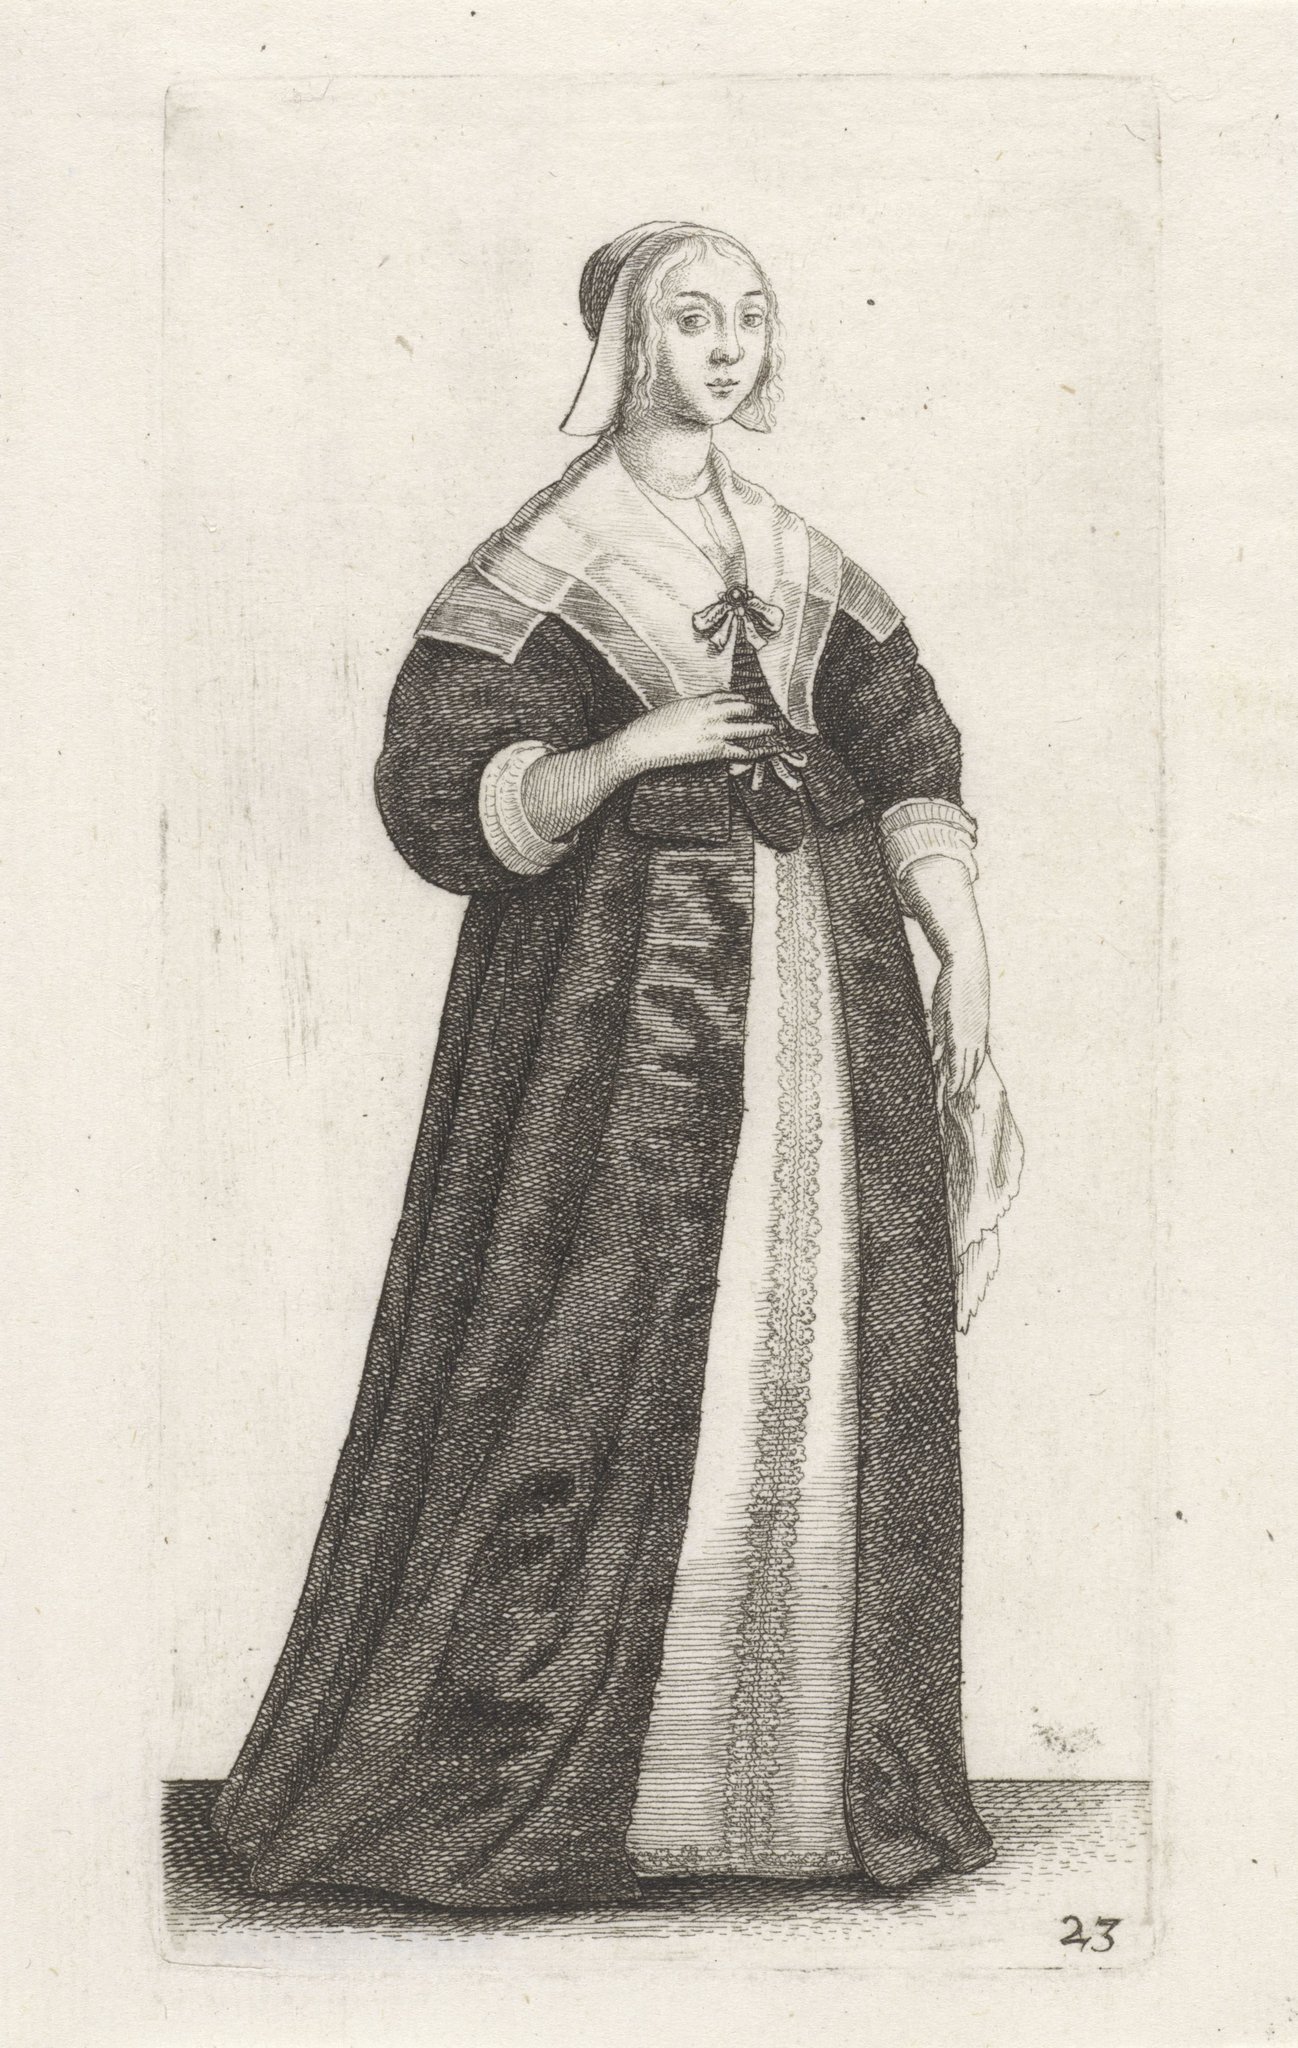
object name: costume print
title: Ornatus Muliebris Anglicanus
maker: wenceslaus hollar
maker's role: draughtsman, print maker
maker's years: 1607-1677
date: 1638-1640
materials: paper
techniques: etching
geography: london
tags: bow (ornamental part of clothing) (+ women's clothes), handkerchief (+ women's clothes), brooch, agraffe, clasp (+ women's clothes), neck-gear ~ clothing (neckerchief) (+ women's clothes), piece of clothing covering the breast or décolleté (stomacher) (+ women's clothes), europeans: englishmen (+ women), skirt (underskirt) (+ women's clothes), styles of hairdress - aa - ~ women, head-gear: cap (+ women's clothes), neck-gear: collar (+ women's clothes), fashion plates, skirt (+ women's clothes), sleeves (+ women's clothes), clothing for the upper part of the body (with name) (+ women's clothes), england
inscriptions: collector's mark: Lugt 654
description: Engelse vrouw, met op het afhangende, krullende haar en scheiding in het midden een mutsje met op het voorhoofd teruggeslagen rand die aan weerszijden van het gezicht verbreedt en naar buiten uitstaat. Gekleed in een japon bestaande uit een kort, open lijf met v-hals, hoge taille, schoot met verschillende panden, wijde lange mouwen en borststuk, op een lange, ruime, open rok enigszins slepend op de grond. Licht gekleurde onderrok. Rond de hals een dun, dichtgeknoopt koordje met afhangende uiteinden. Over het décolleté een dubbelgevouwen onversierde, transparante halsdoek, die middenvoor gesloten wordt met een sieraad en een strik. Hieronder een platte, brede kraag de over de schouders hangt. Of het lijf is over het borststuk dicht geregen, of het borststuk is versierd met kruislings geplaatste linten met onderaan een strik. Dubbele, fijn geplooide, teruggeslagen manchetten. De onderrok is middenvoor versierd met twee verticaal, tegen elkaar geplaatste geschulpte stroken kant of passement. No. 23 uit de serie Ornatus Muliebris Anglicanus.